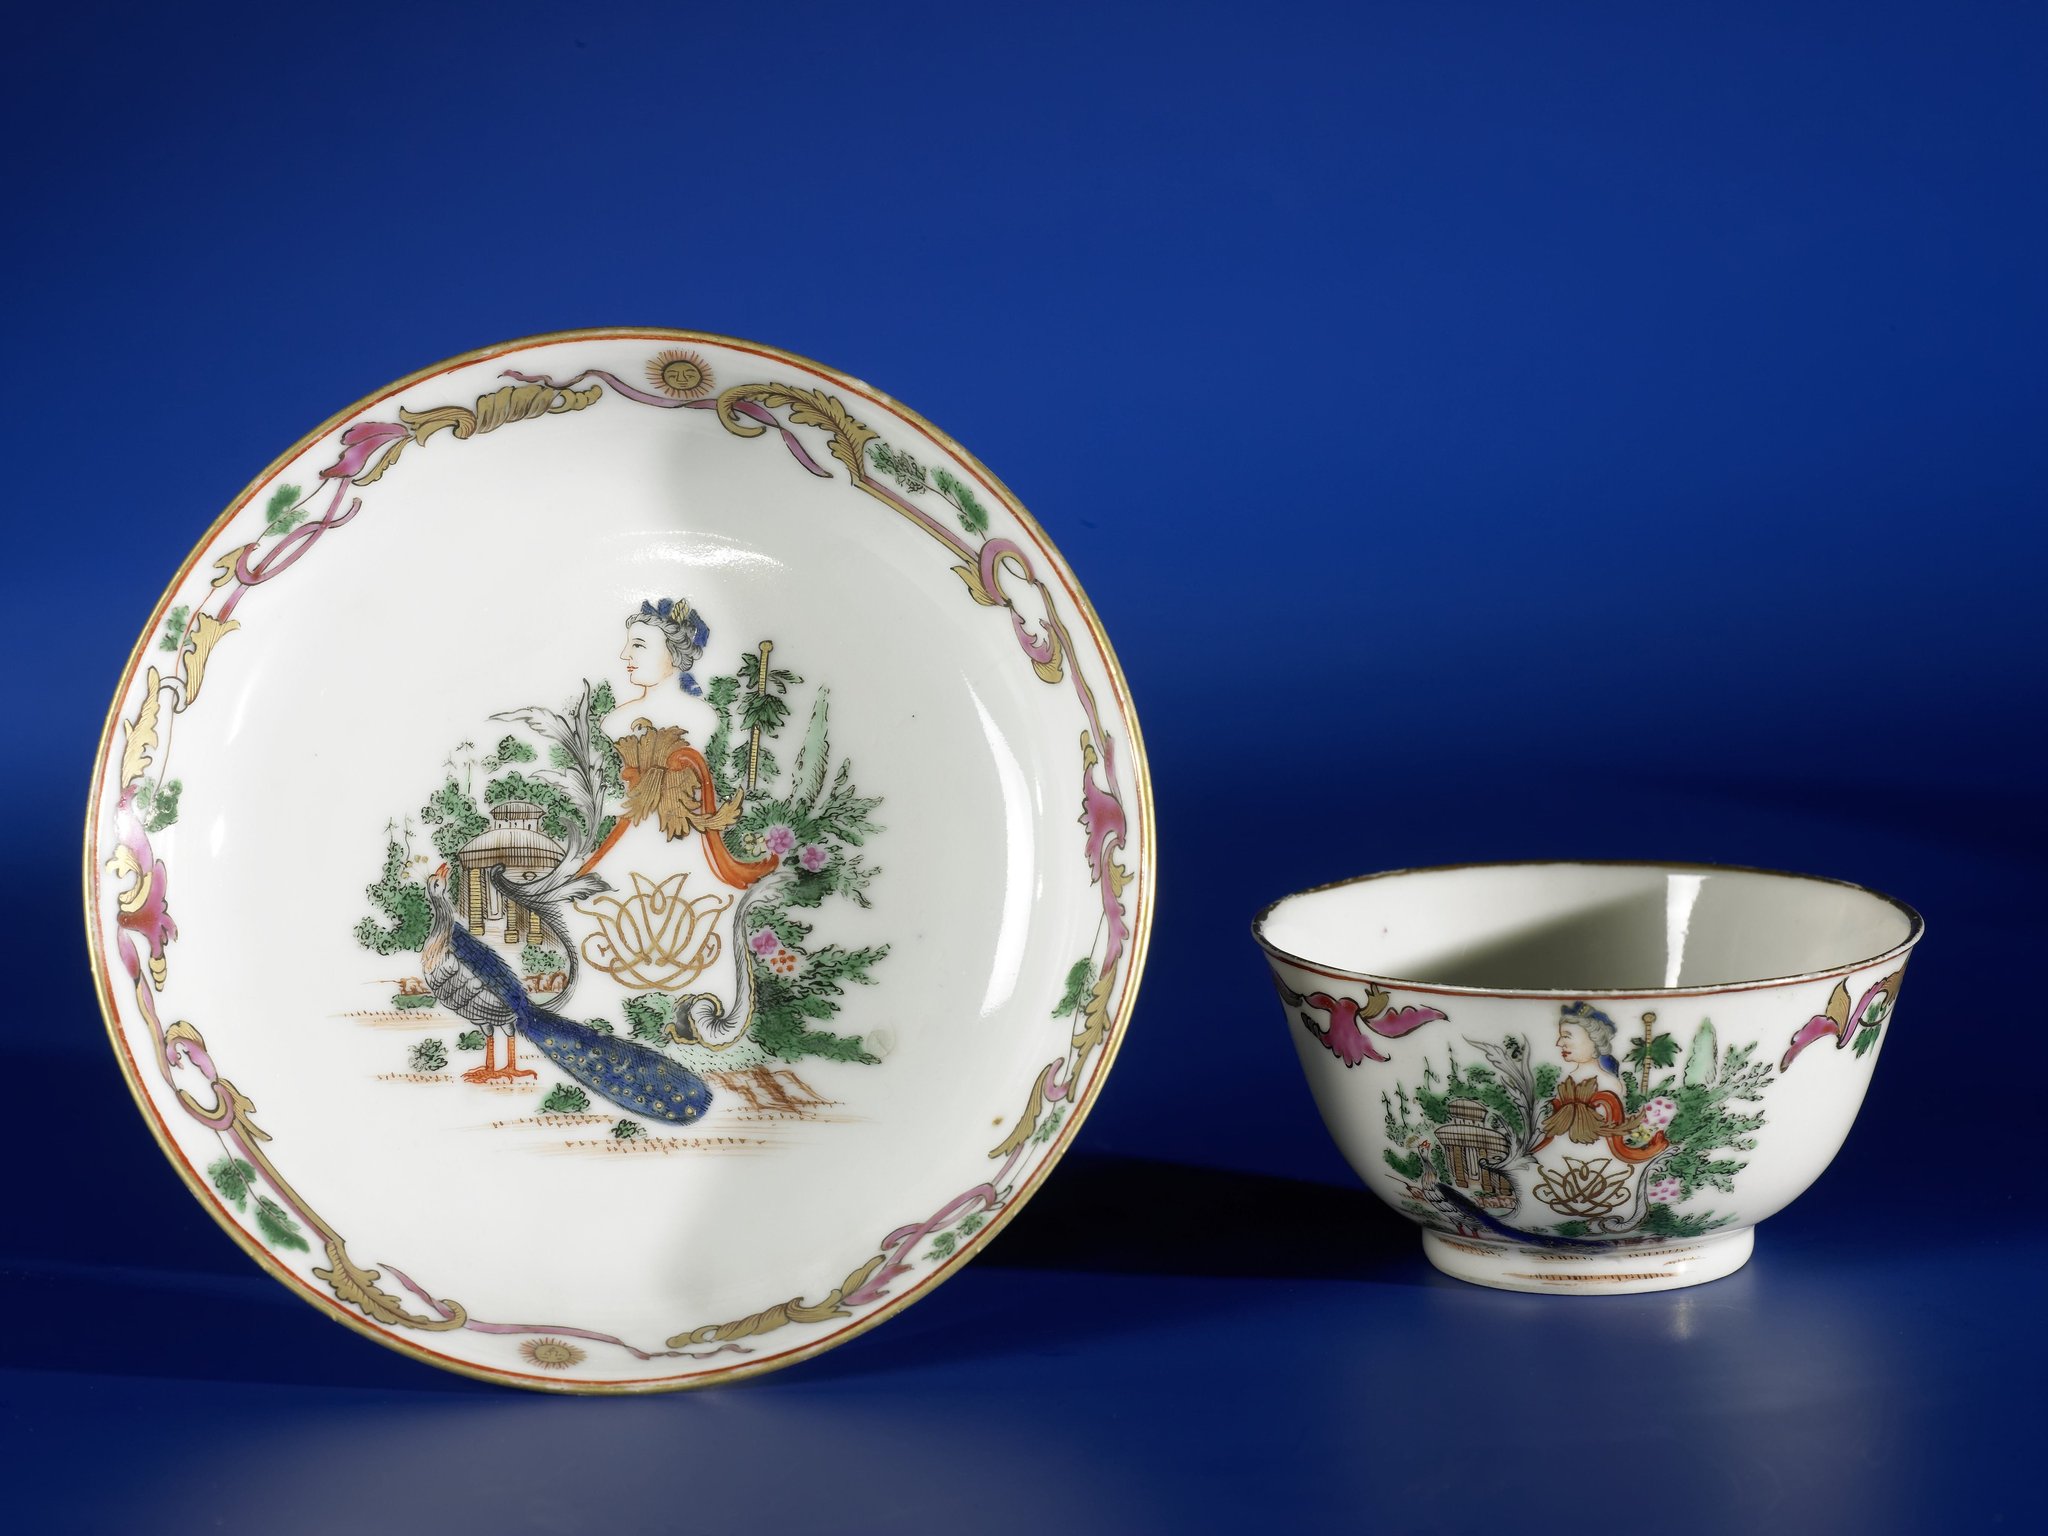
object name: kop en schotel, kop en schotel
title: Bell-shaped cup and saucer with an elaboratly decorated monogram 'IDF'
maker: Anonymous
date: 1750-1774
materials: glaze, gold, paint, porcelain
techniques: firing, gilding, turning, vitrification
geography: china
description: Wijd uitlopende kop en schotel op een voetring, gedecoreerd in emailkleuren en goud. Centraal een monogram met de initialen IDF. Daar omheen een landschap met bomen, bloemen en een pauw en een Grieks uitziend rond tempeltje. Bovenaan een buste van een Grieks uitziende dame. Op de rand een decoratief patroon met boven en onder een zonnetje.